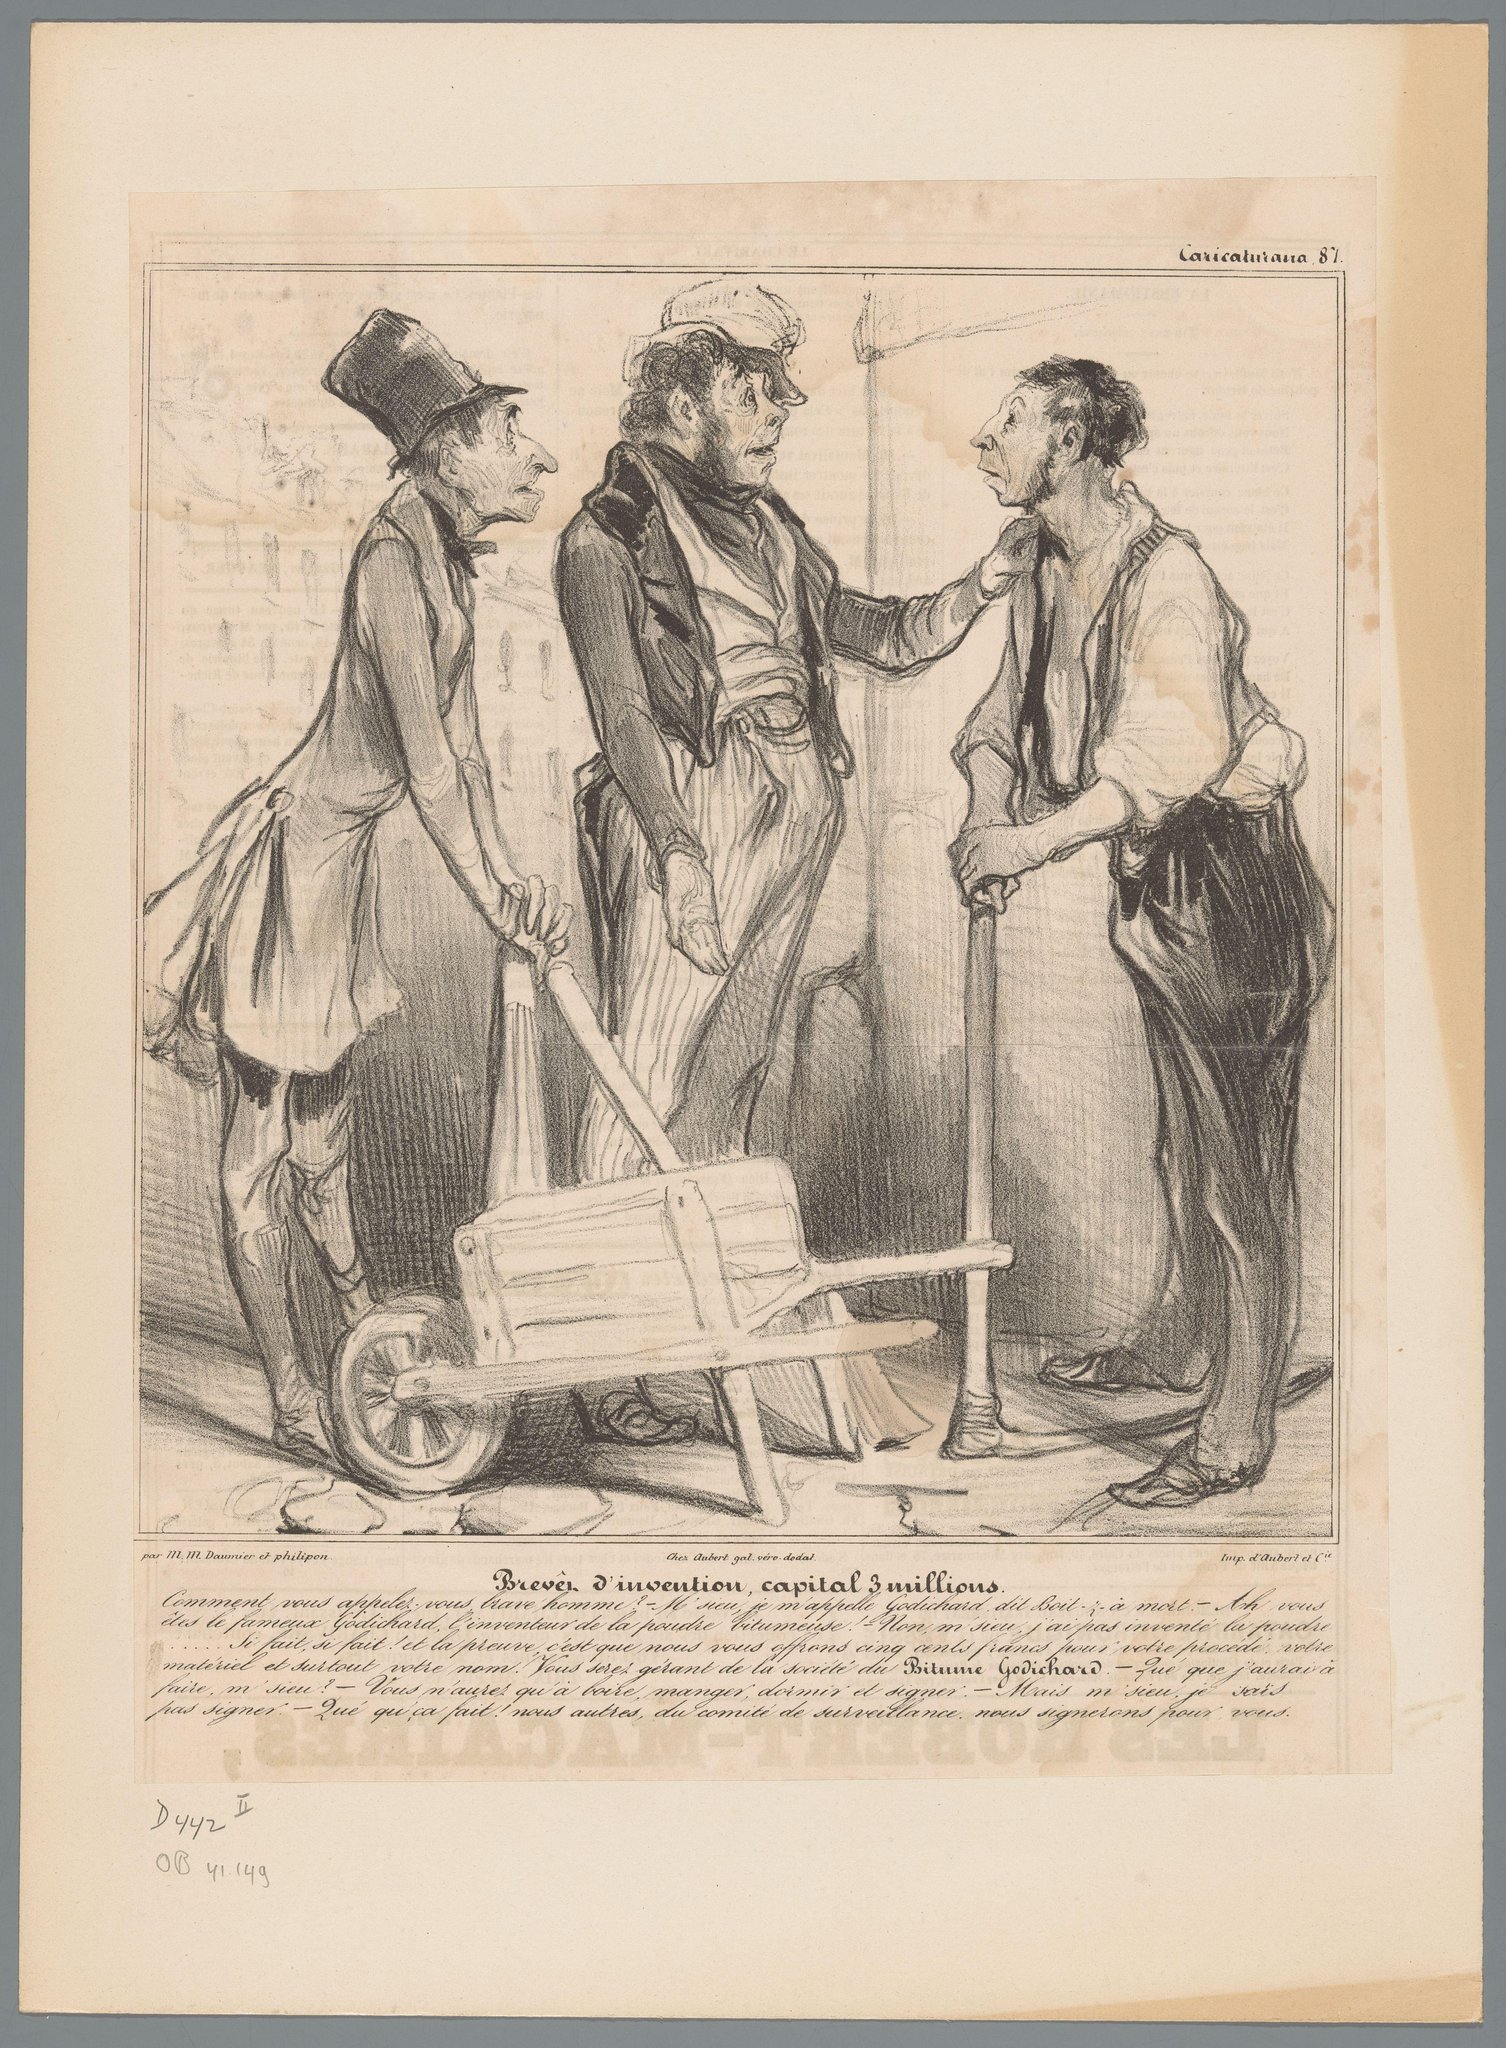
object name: cartoon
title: Robert Macaire en Bertrand doen een grondwerker een voorstel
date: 1838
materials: paper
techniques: letterpress printing, lithograph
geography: paris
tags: caricatures (human types), employer ~ employee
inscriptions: collector's mark: Lugt 2228a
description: Prent mogelijk uit: Le Charivari, 19 augustus 1838.